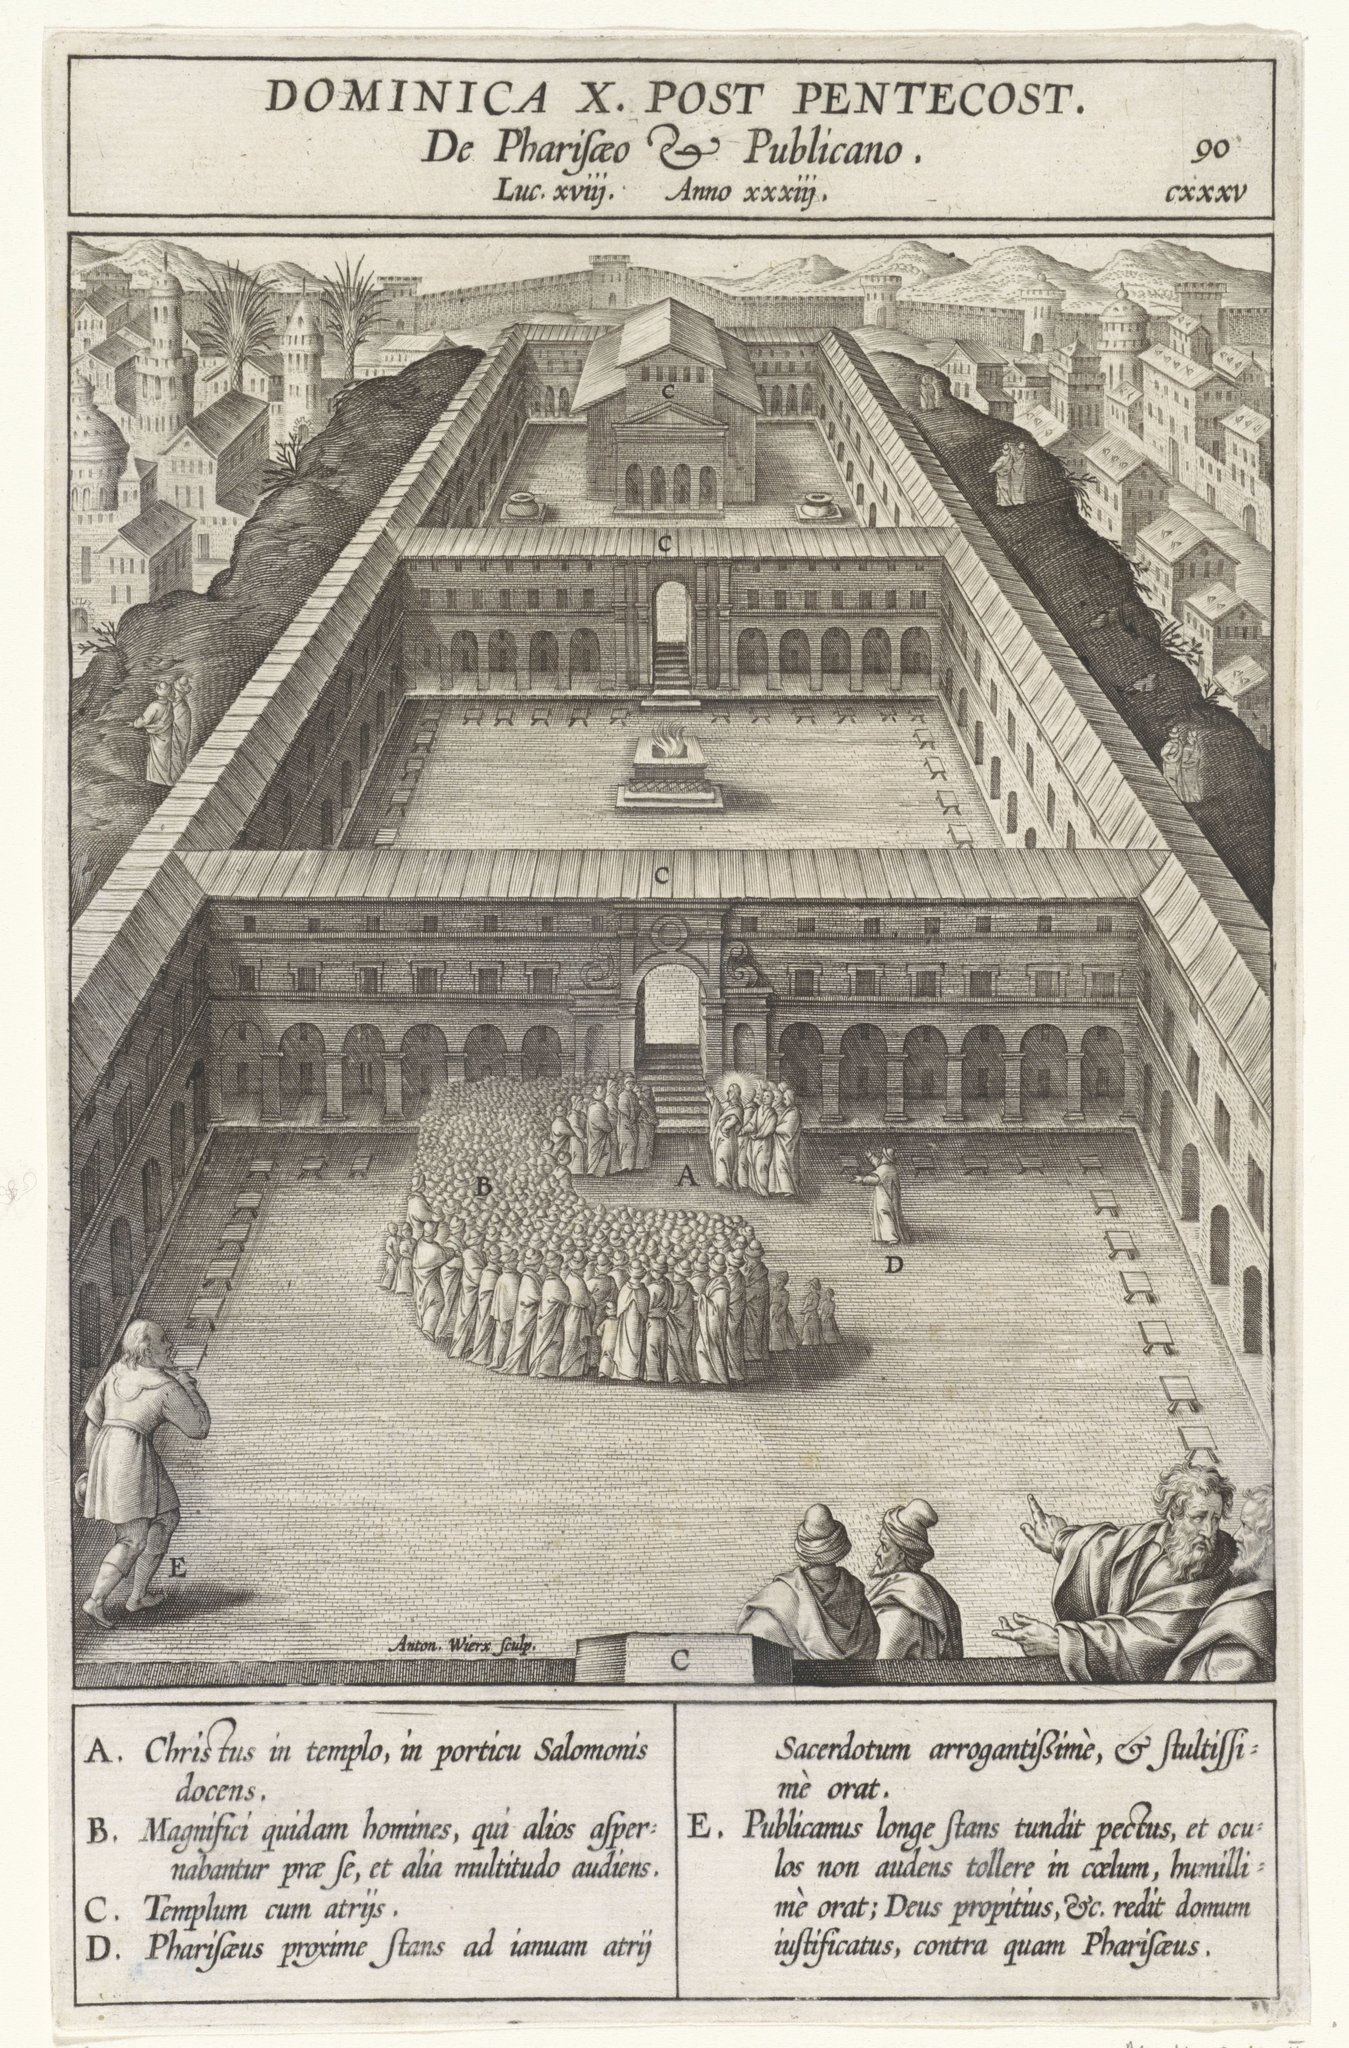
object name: print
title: Dominica X. Post Pentecost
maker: antonie wierix (ii)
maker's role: draughtsman, print maker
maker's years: 1555-1604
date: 1593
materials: paper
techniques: engraving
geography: antwerp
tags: the praying pharisee and the repentant publican in the temple (luke 18:10-14)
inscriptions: collector's mark: Lugt 2165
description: Christus vertelt de gelijkenis van de farizeeër en de tollenaar in de tempel. De mensen proberen ook kleine kinderen bij hem te brengen. Bij verschillende elementen uit de voorstelling staan letters die corresponderen met de legenda in de marge.